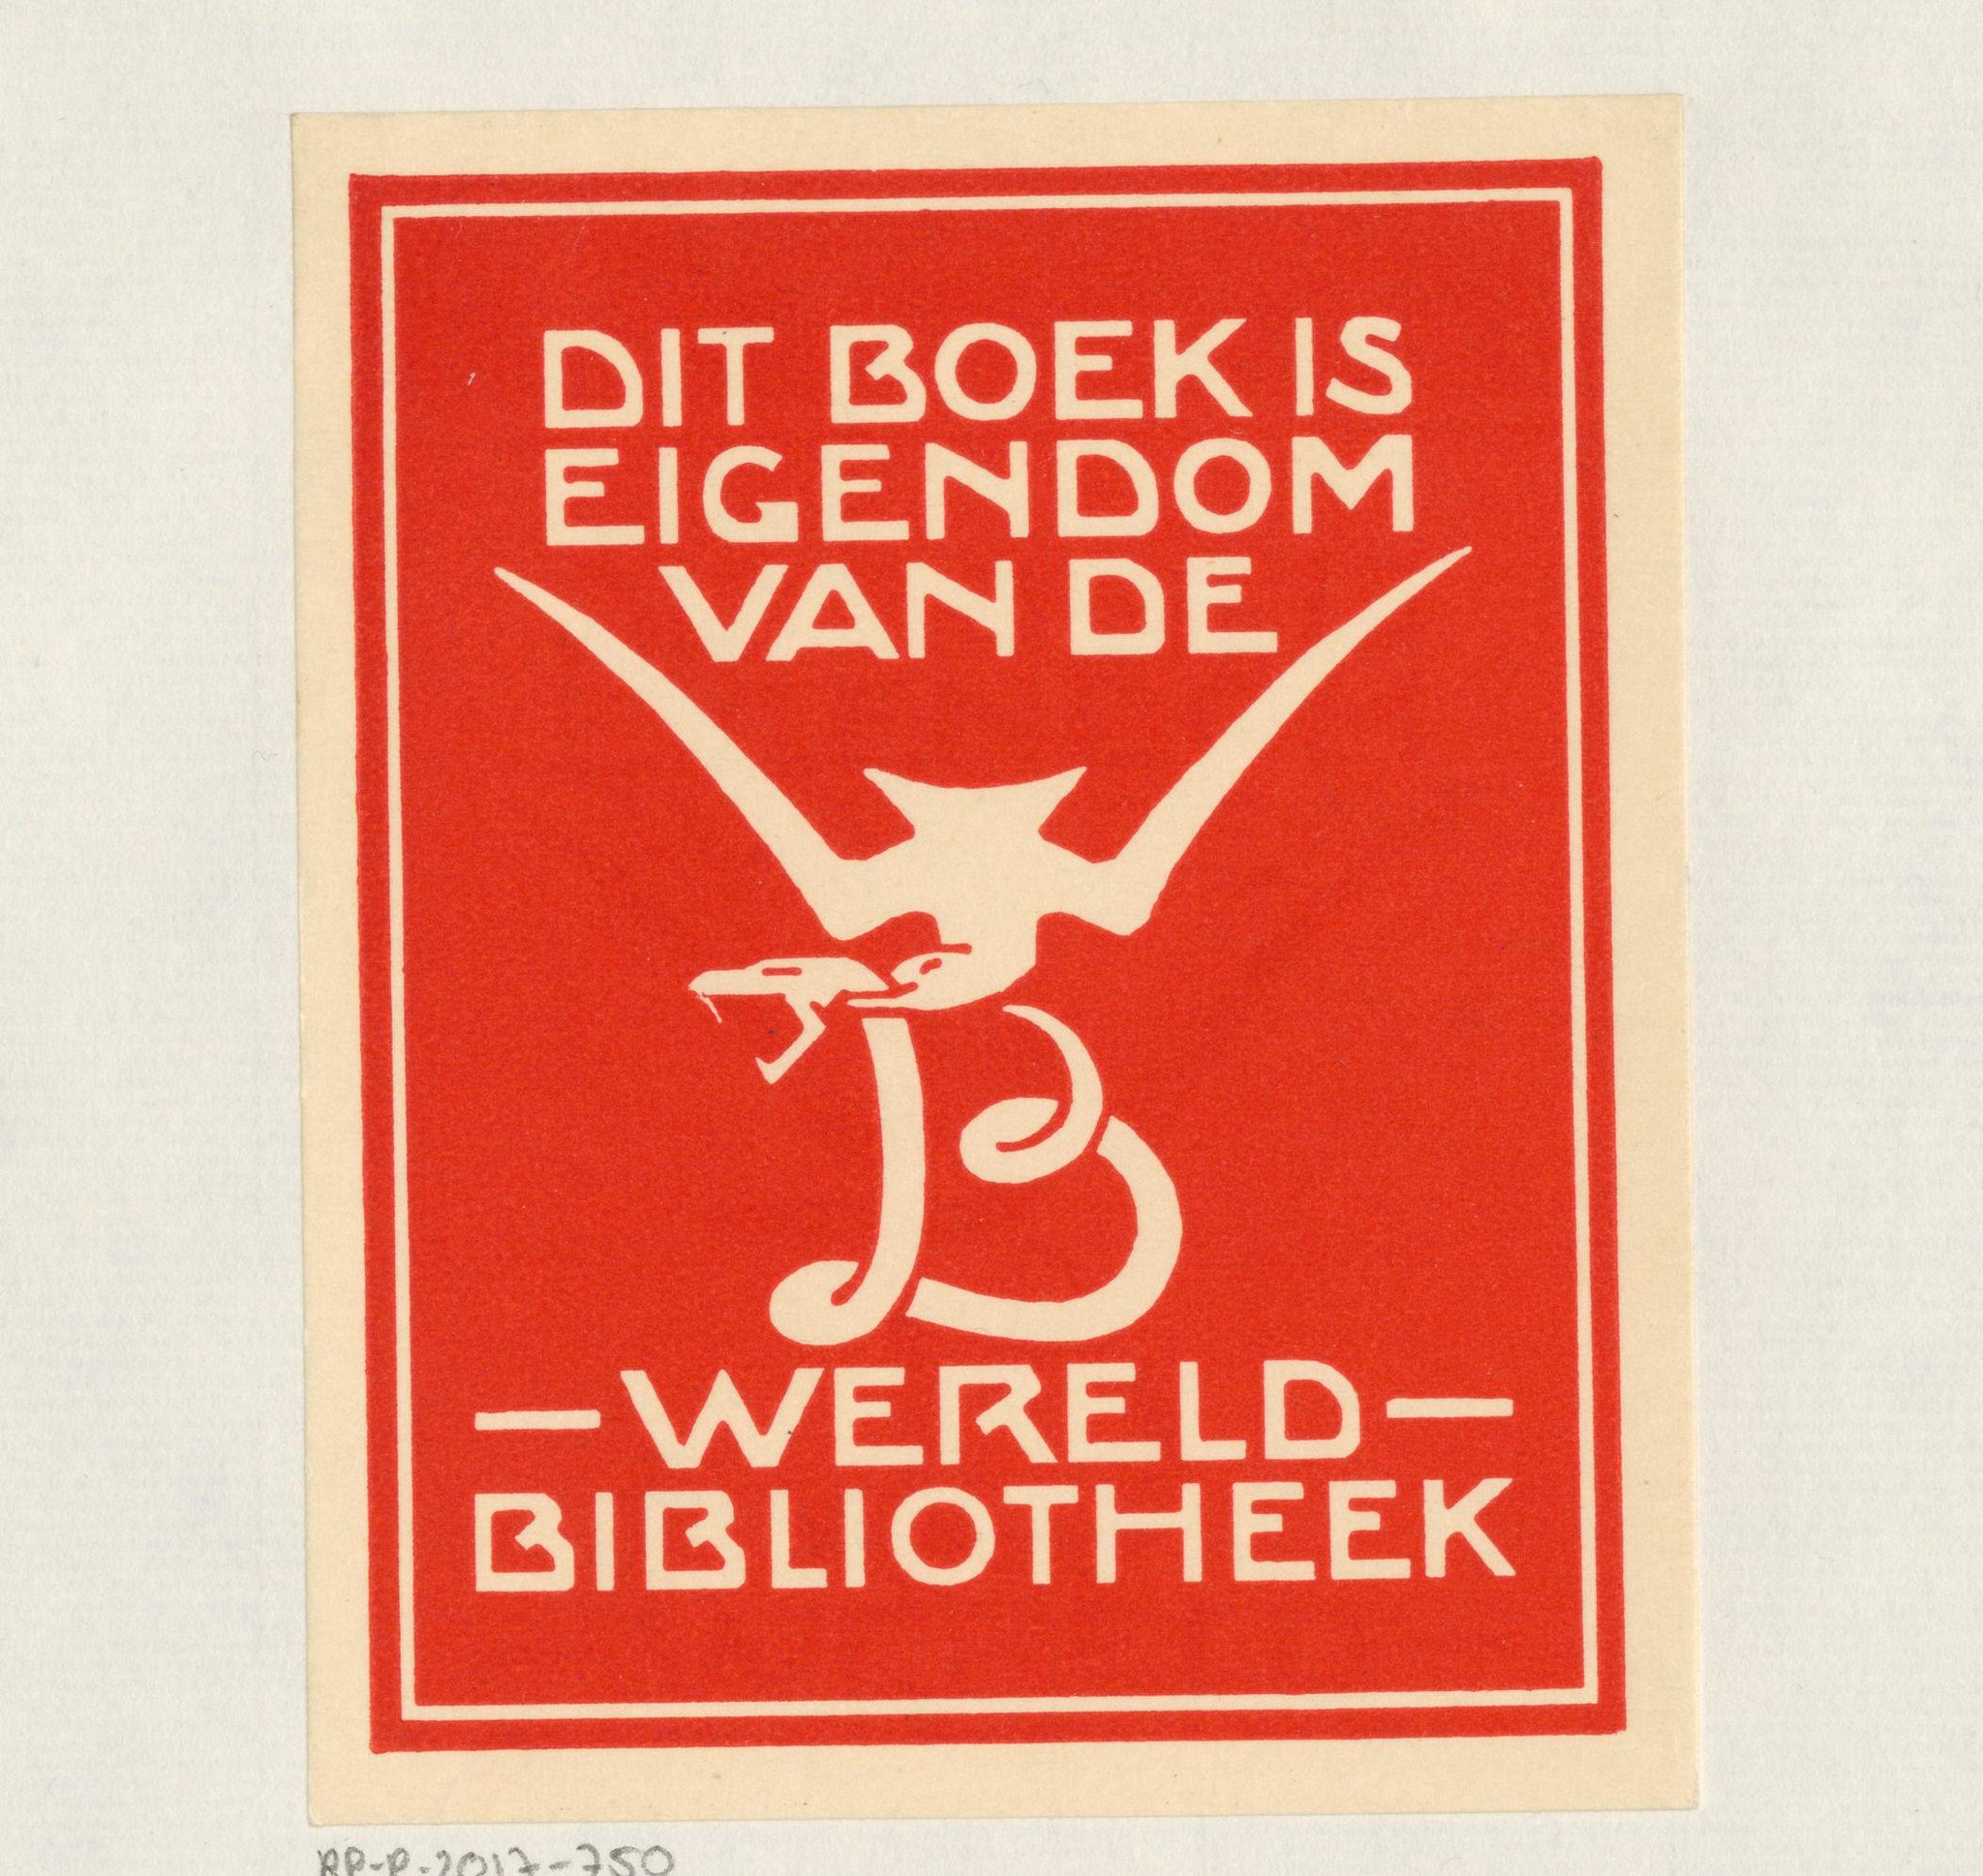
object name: bookplate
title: Ex libris van de Wereldbibliotheek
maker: Anonymous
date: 1931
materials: paper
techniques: printing block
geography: netherlands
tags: publisher, snakes, birds